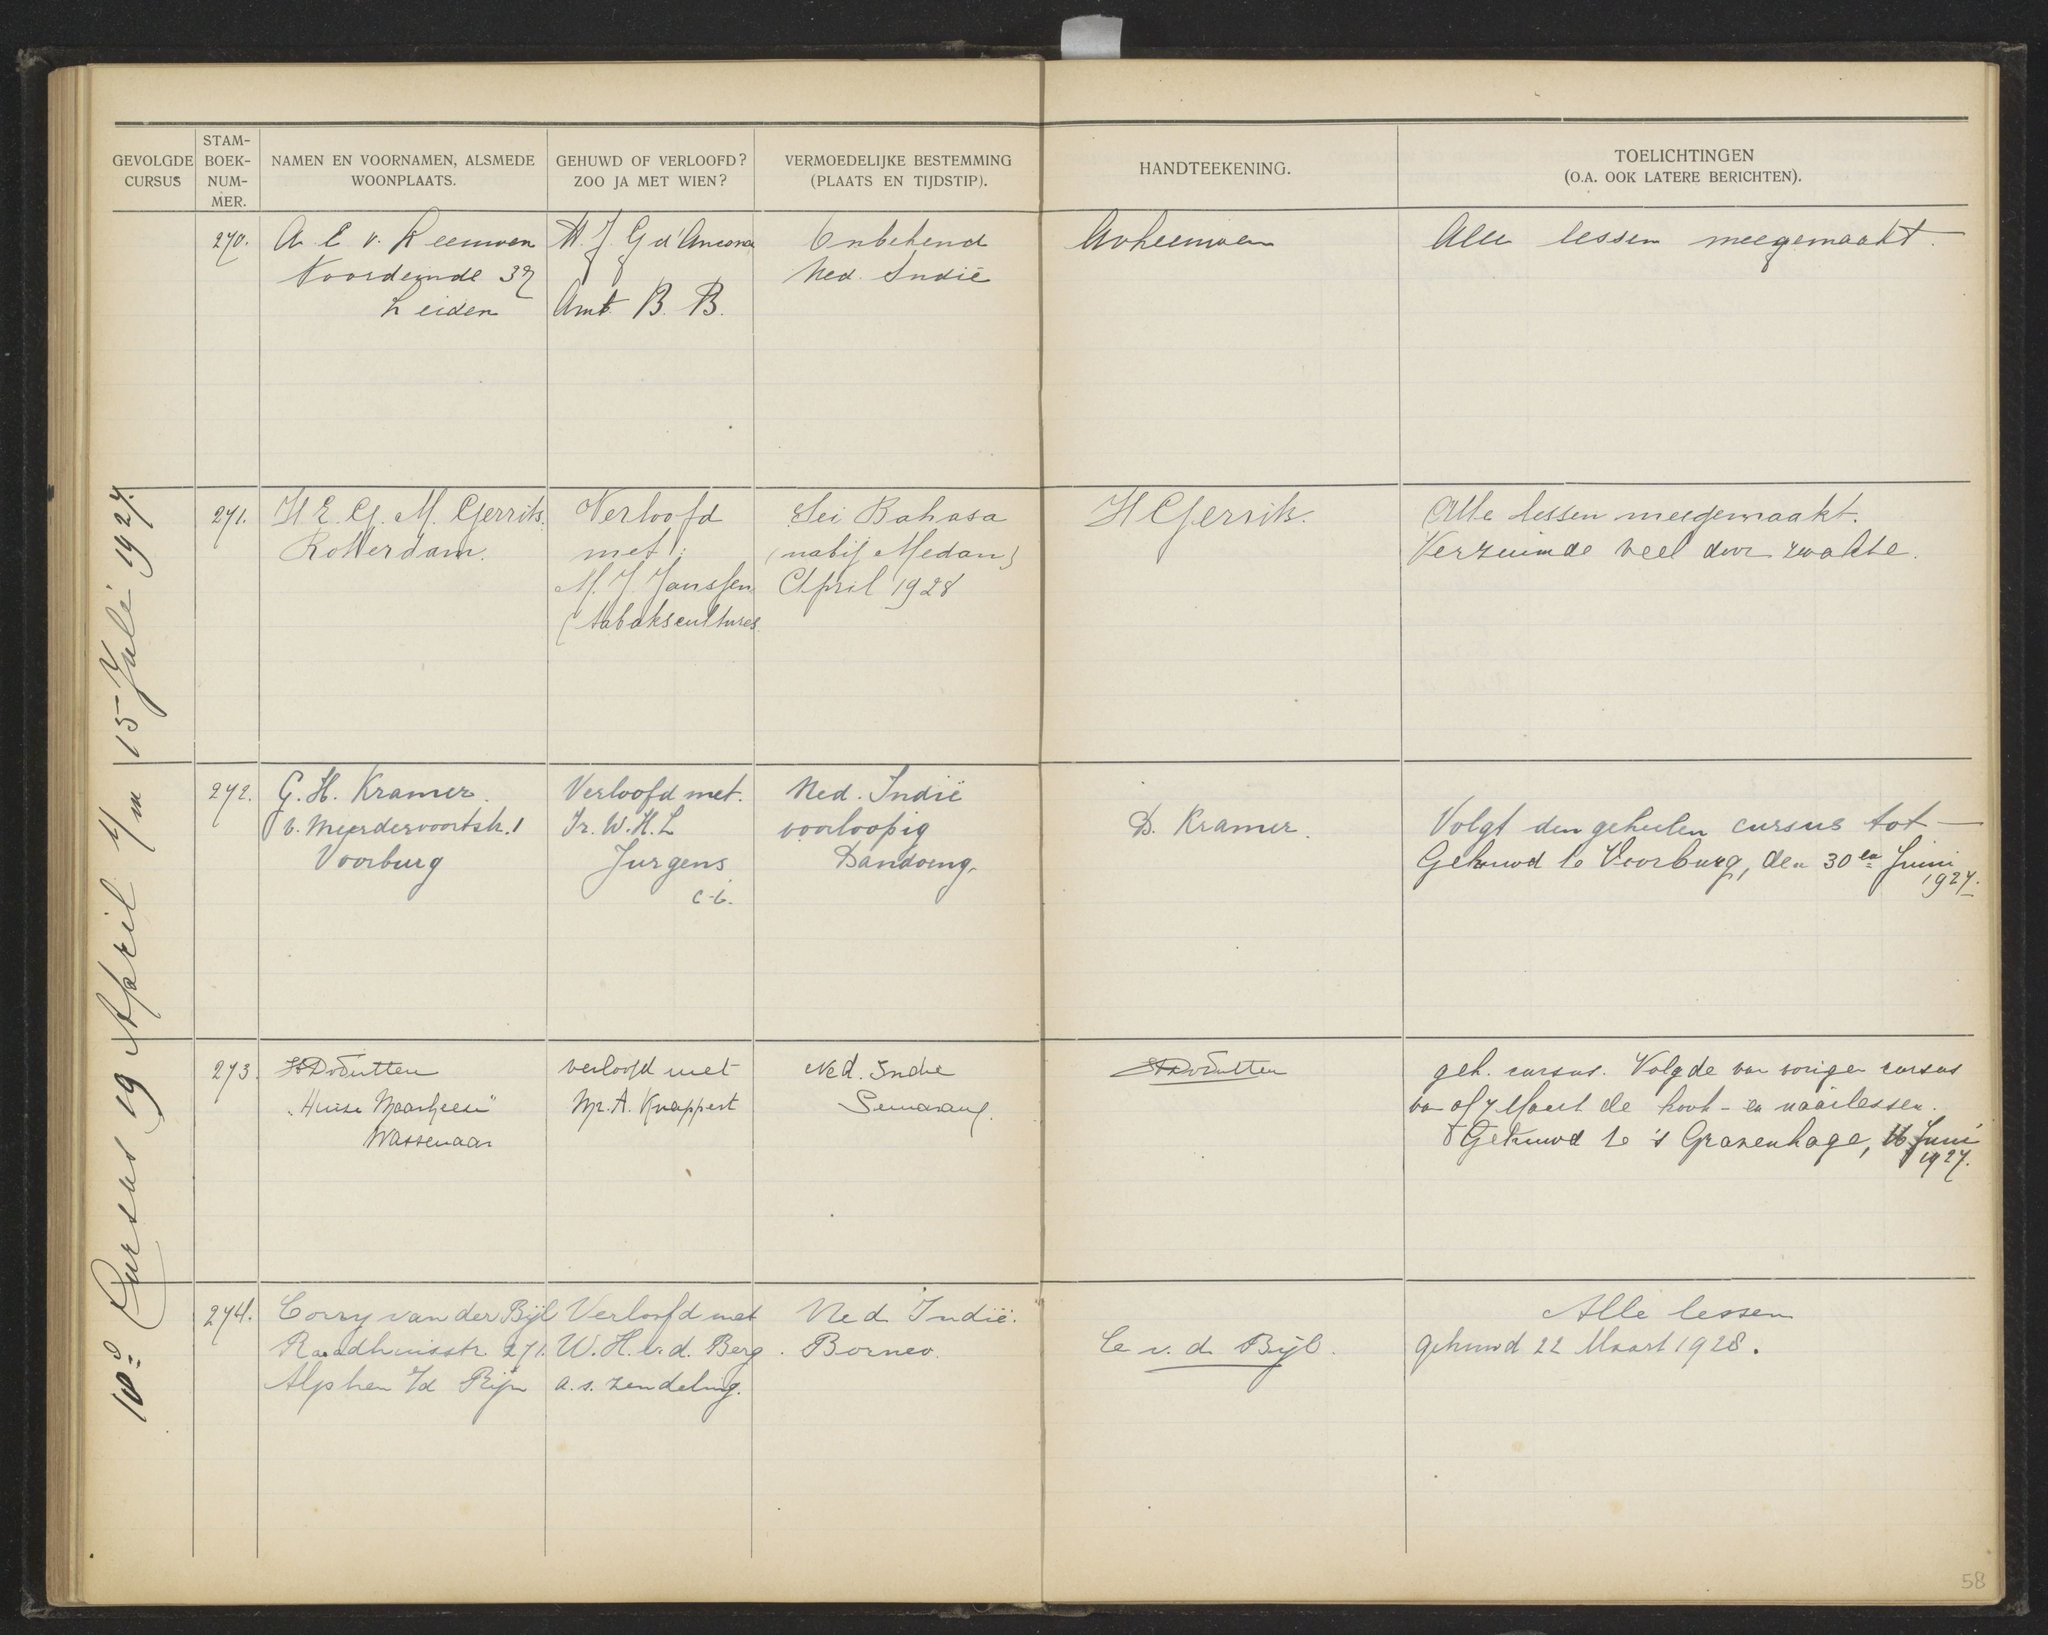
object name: album leaf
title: Blad 58 uit Stamboek van de leerlingen der Koloniale School voor Meisjes en Vrouwen te 's-Gravenhage deel I (1921-1929)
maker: Anonymous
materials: paper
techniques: printing, writing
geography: the hague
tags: further education (+ pupil), further education, the hague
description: Twee pagina's met gegevens van de deelnemers aan de 18e driemaandelijkse cursus van 19 april tot en met 15 juli 1927, stamboeknummers 270 tot en met 274. Onderdeel van Stamboek van de leerlingen der Koloniale School voor Meisjes en Vrouwen te 's-Gravenhage deel I (1921-1929).